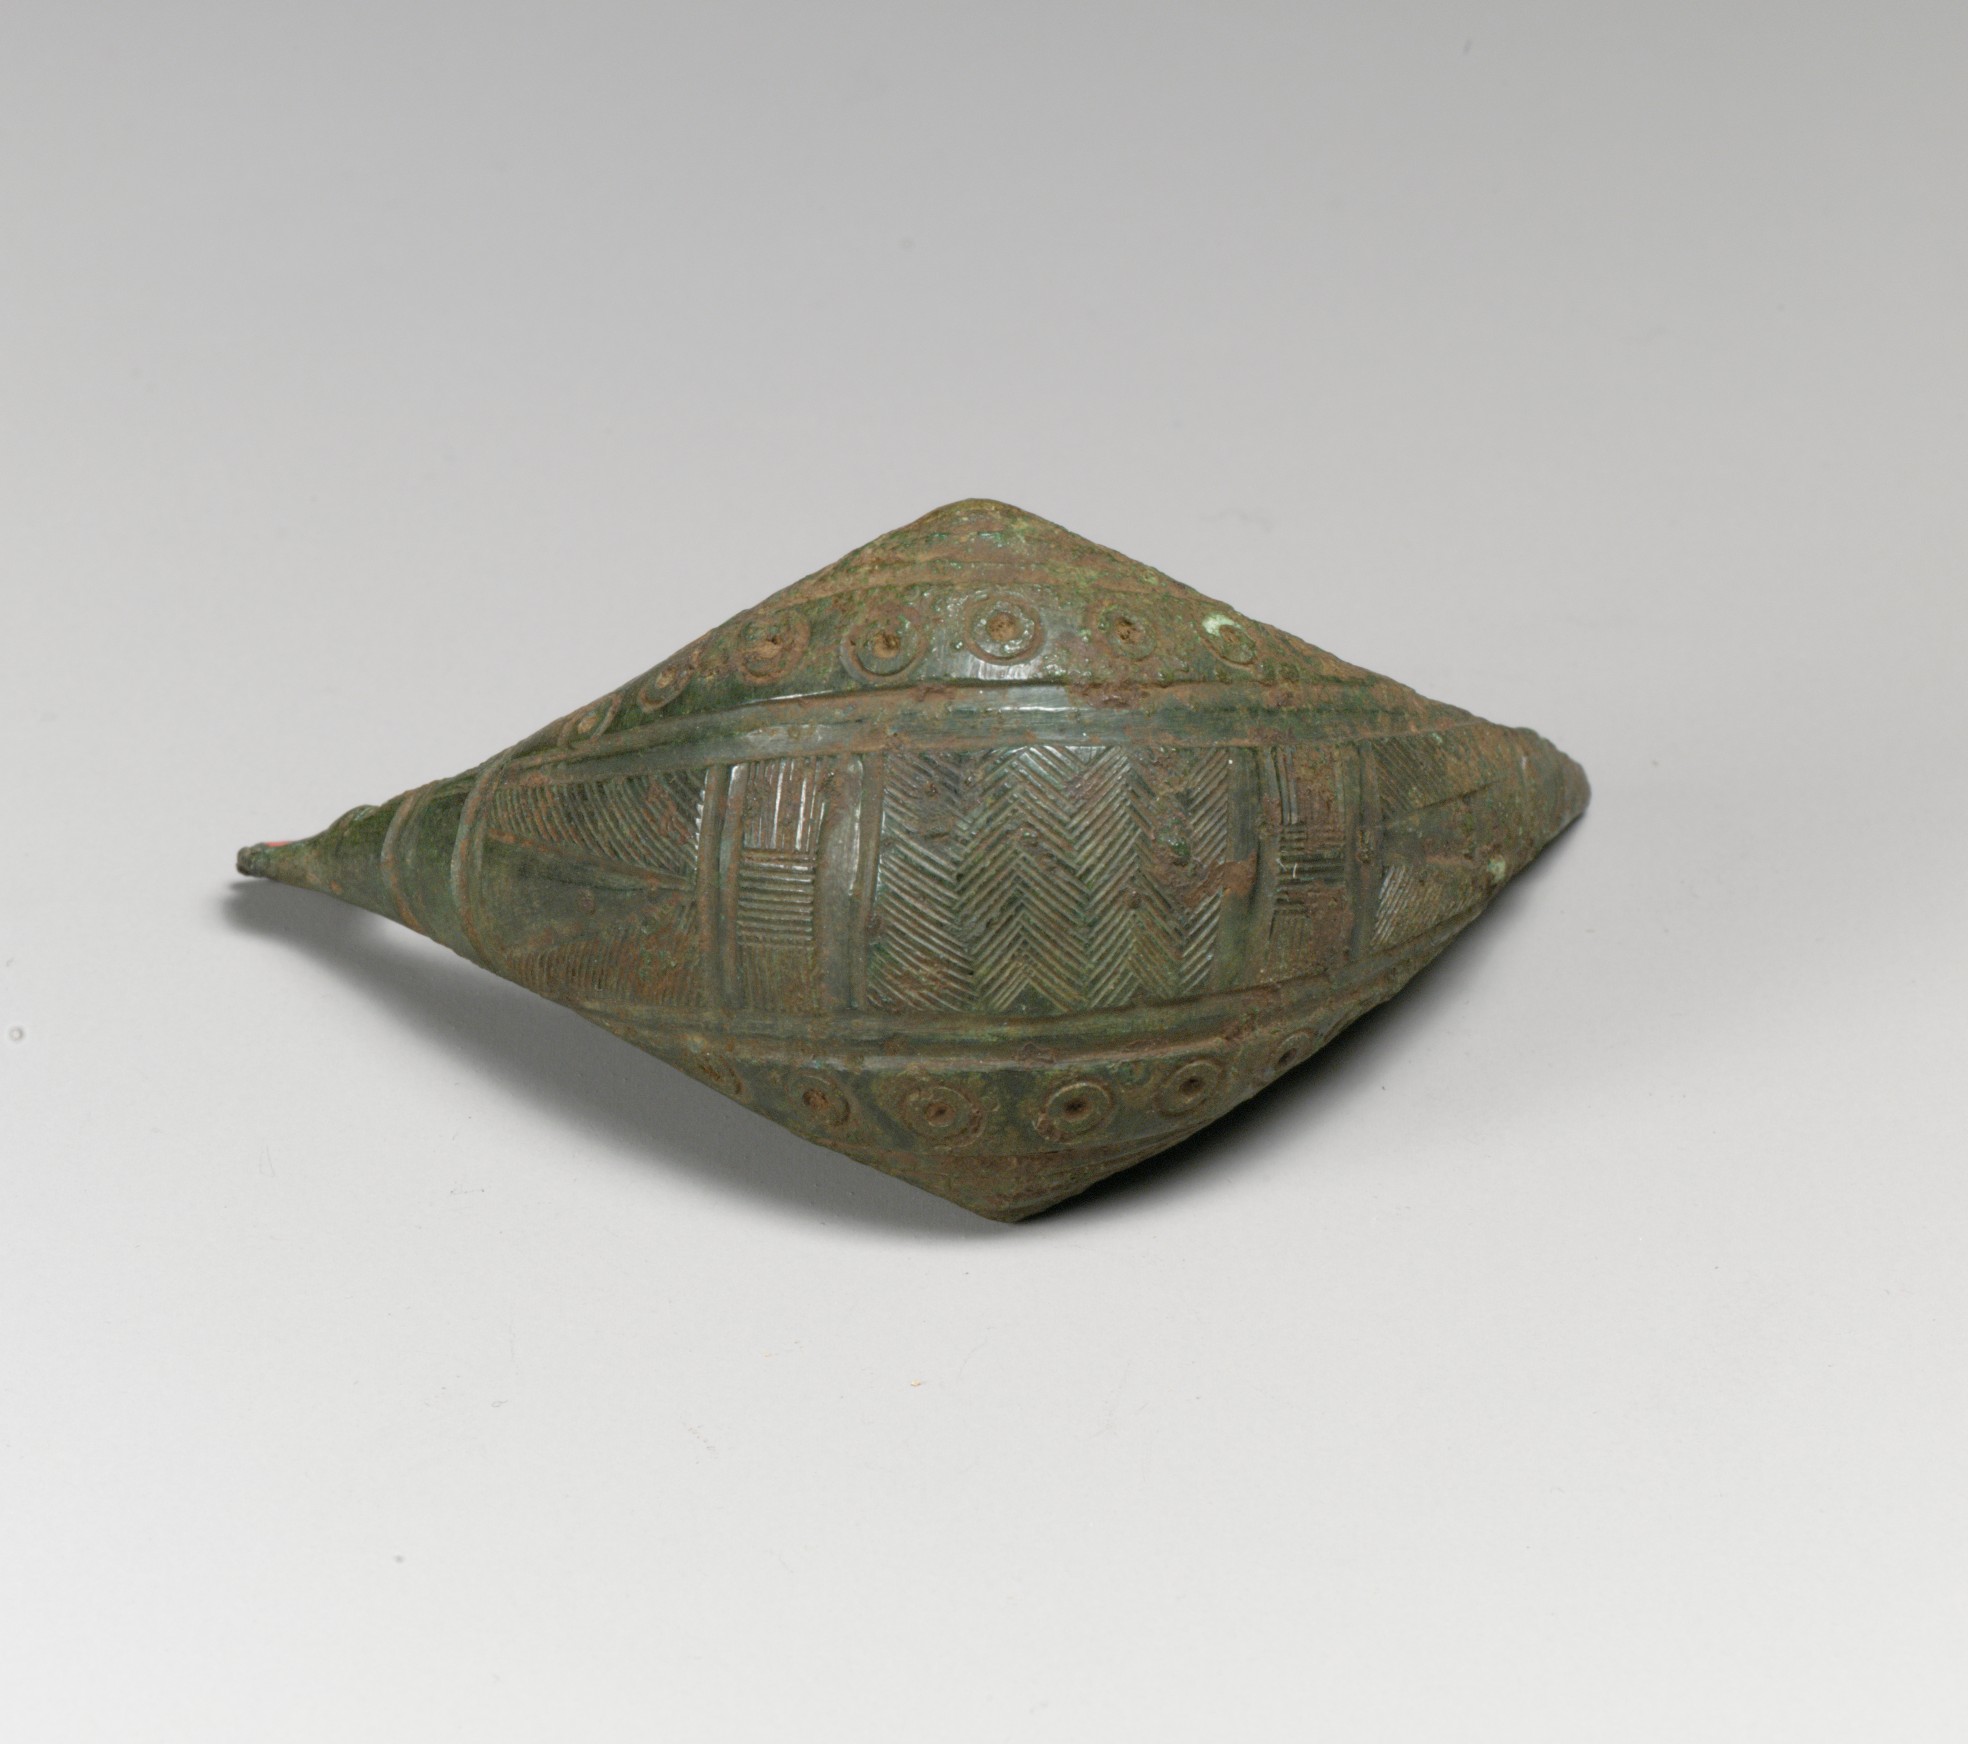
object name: fibula, boat shaped type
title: Fibula, boat-shaped type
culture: italic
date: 800-701 BCE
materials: bronze